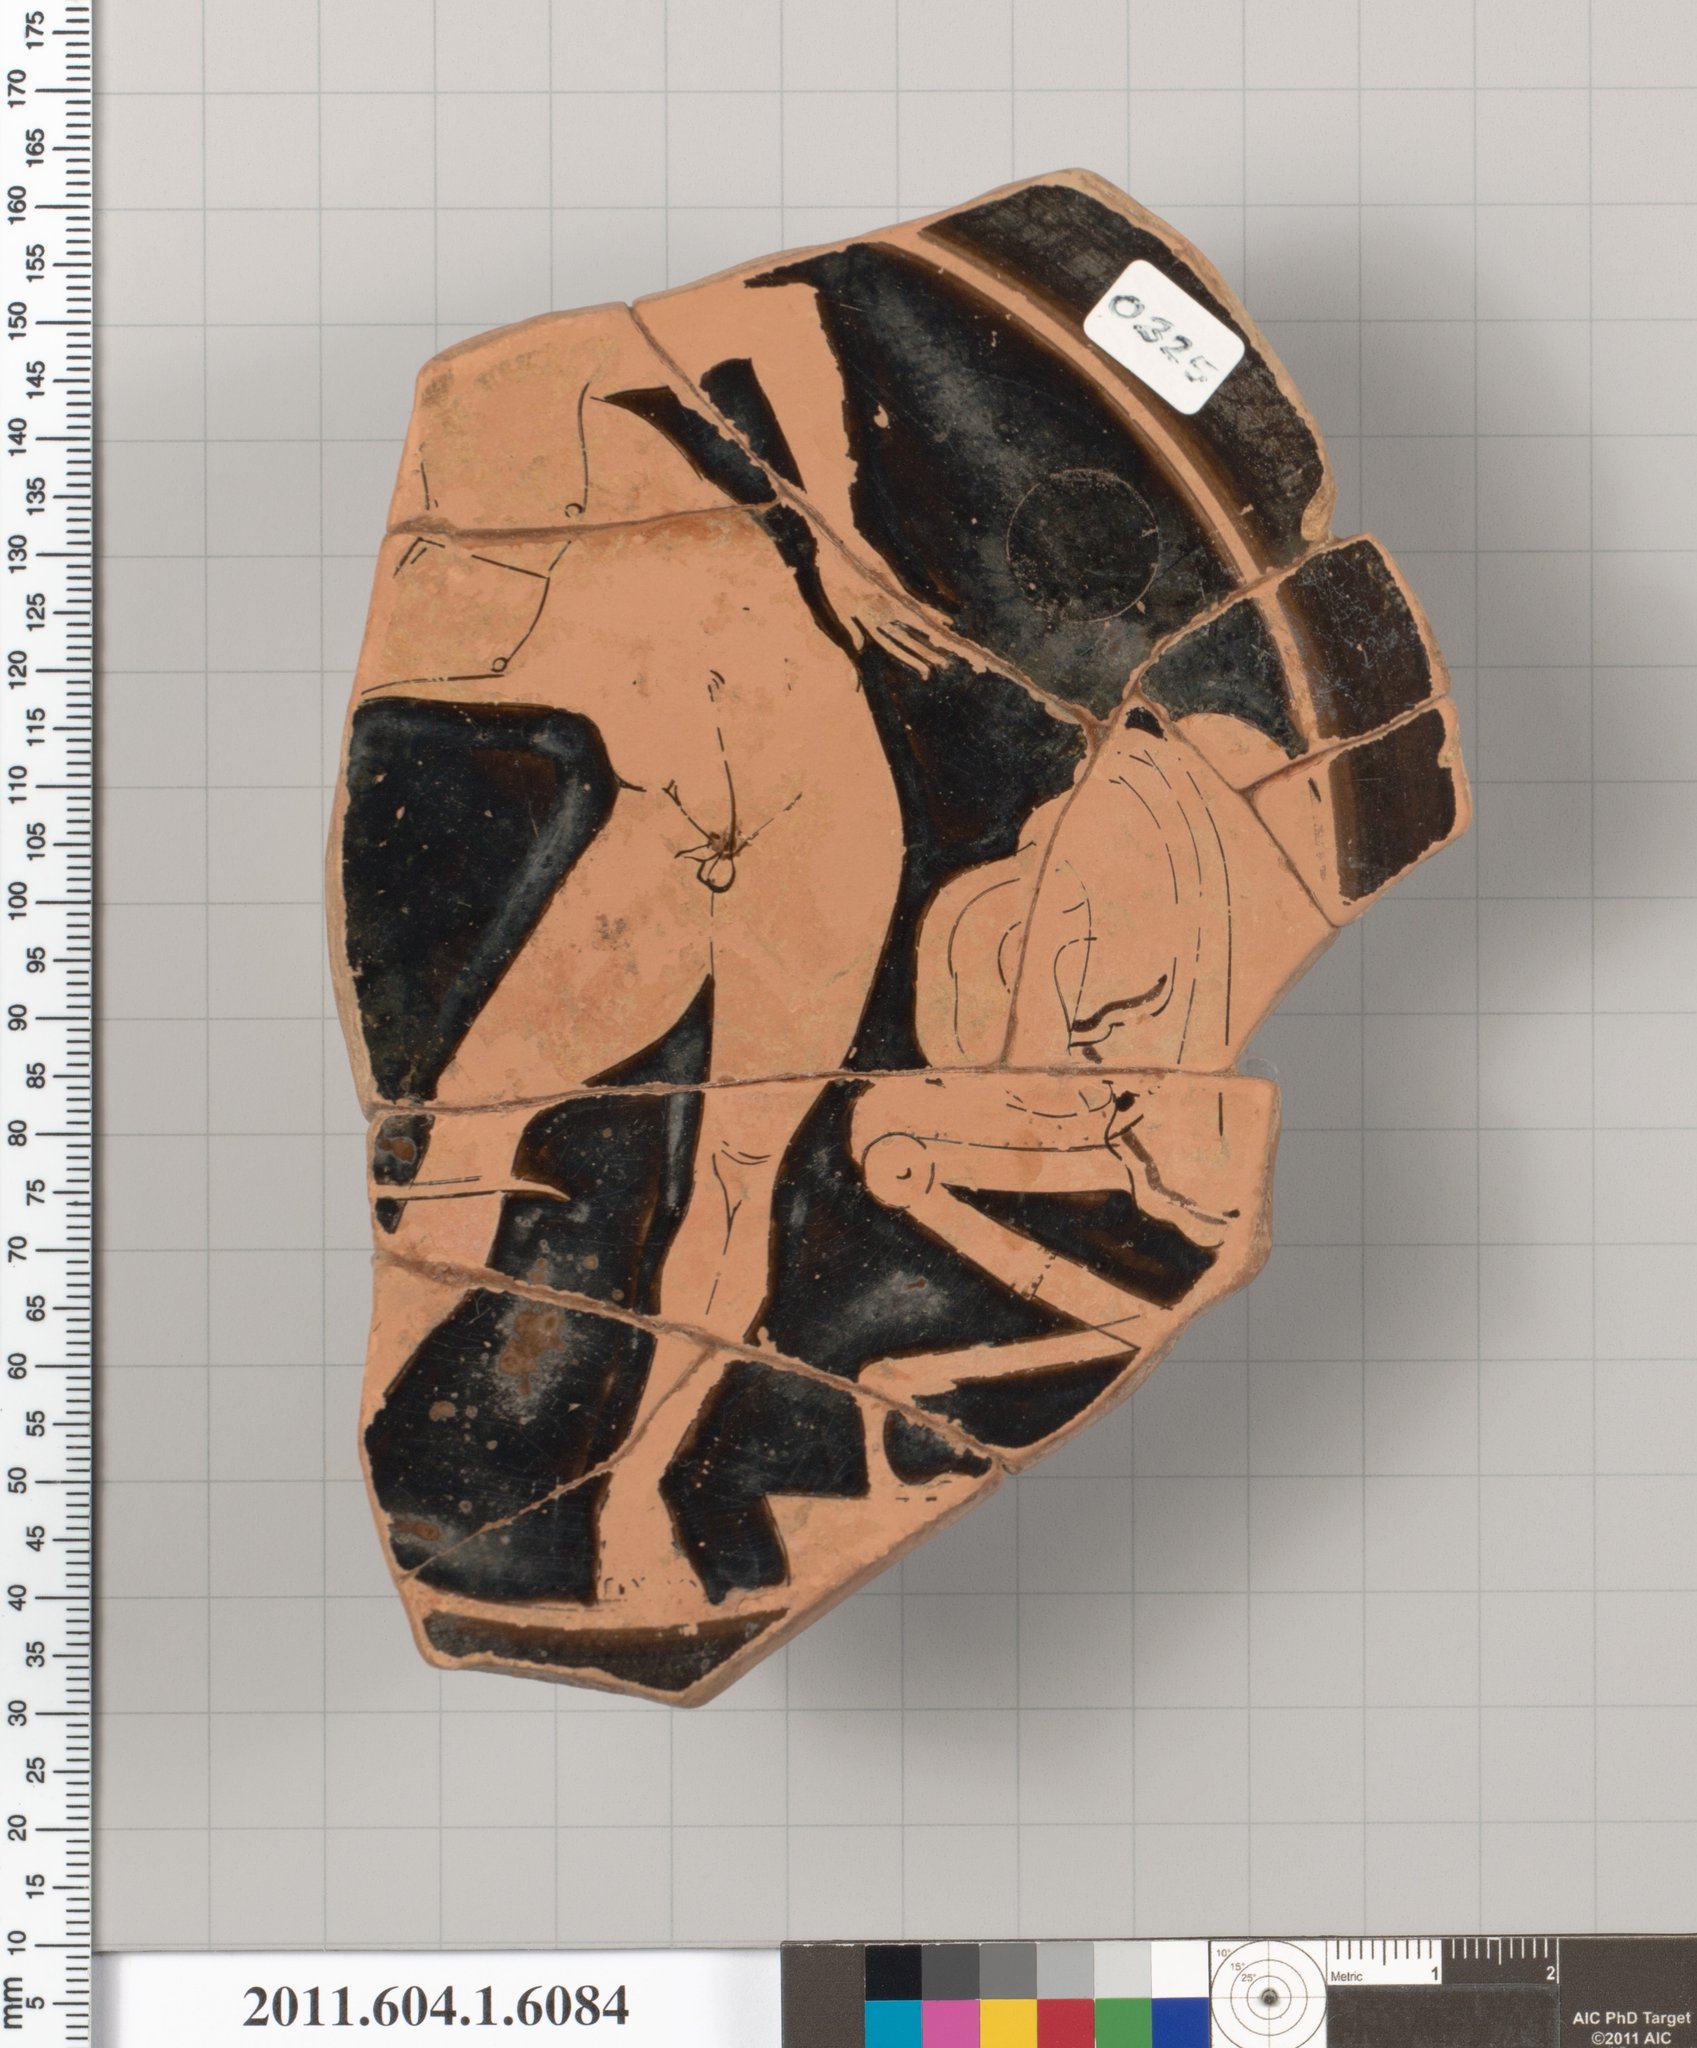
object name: kylix fragment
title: Terracotta fragment of a kylix (drinking cup)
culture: greek, attic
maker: apollodoros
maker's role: artist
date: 500-490 BCE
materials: terracotta